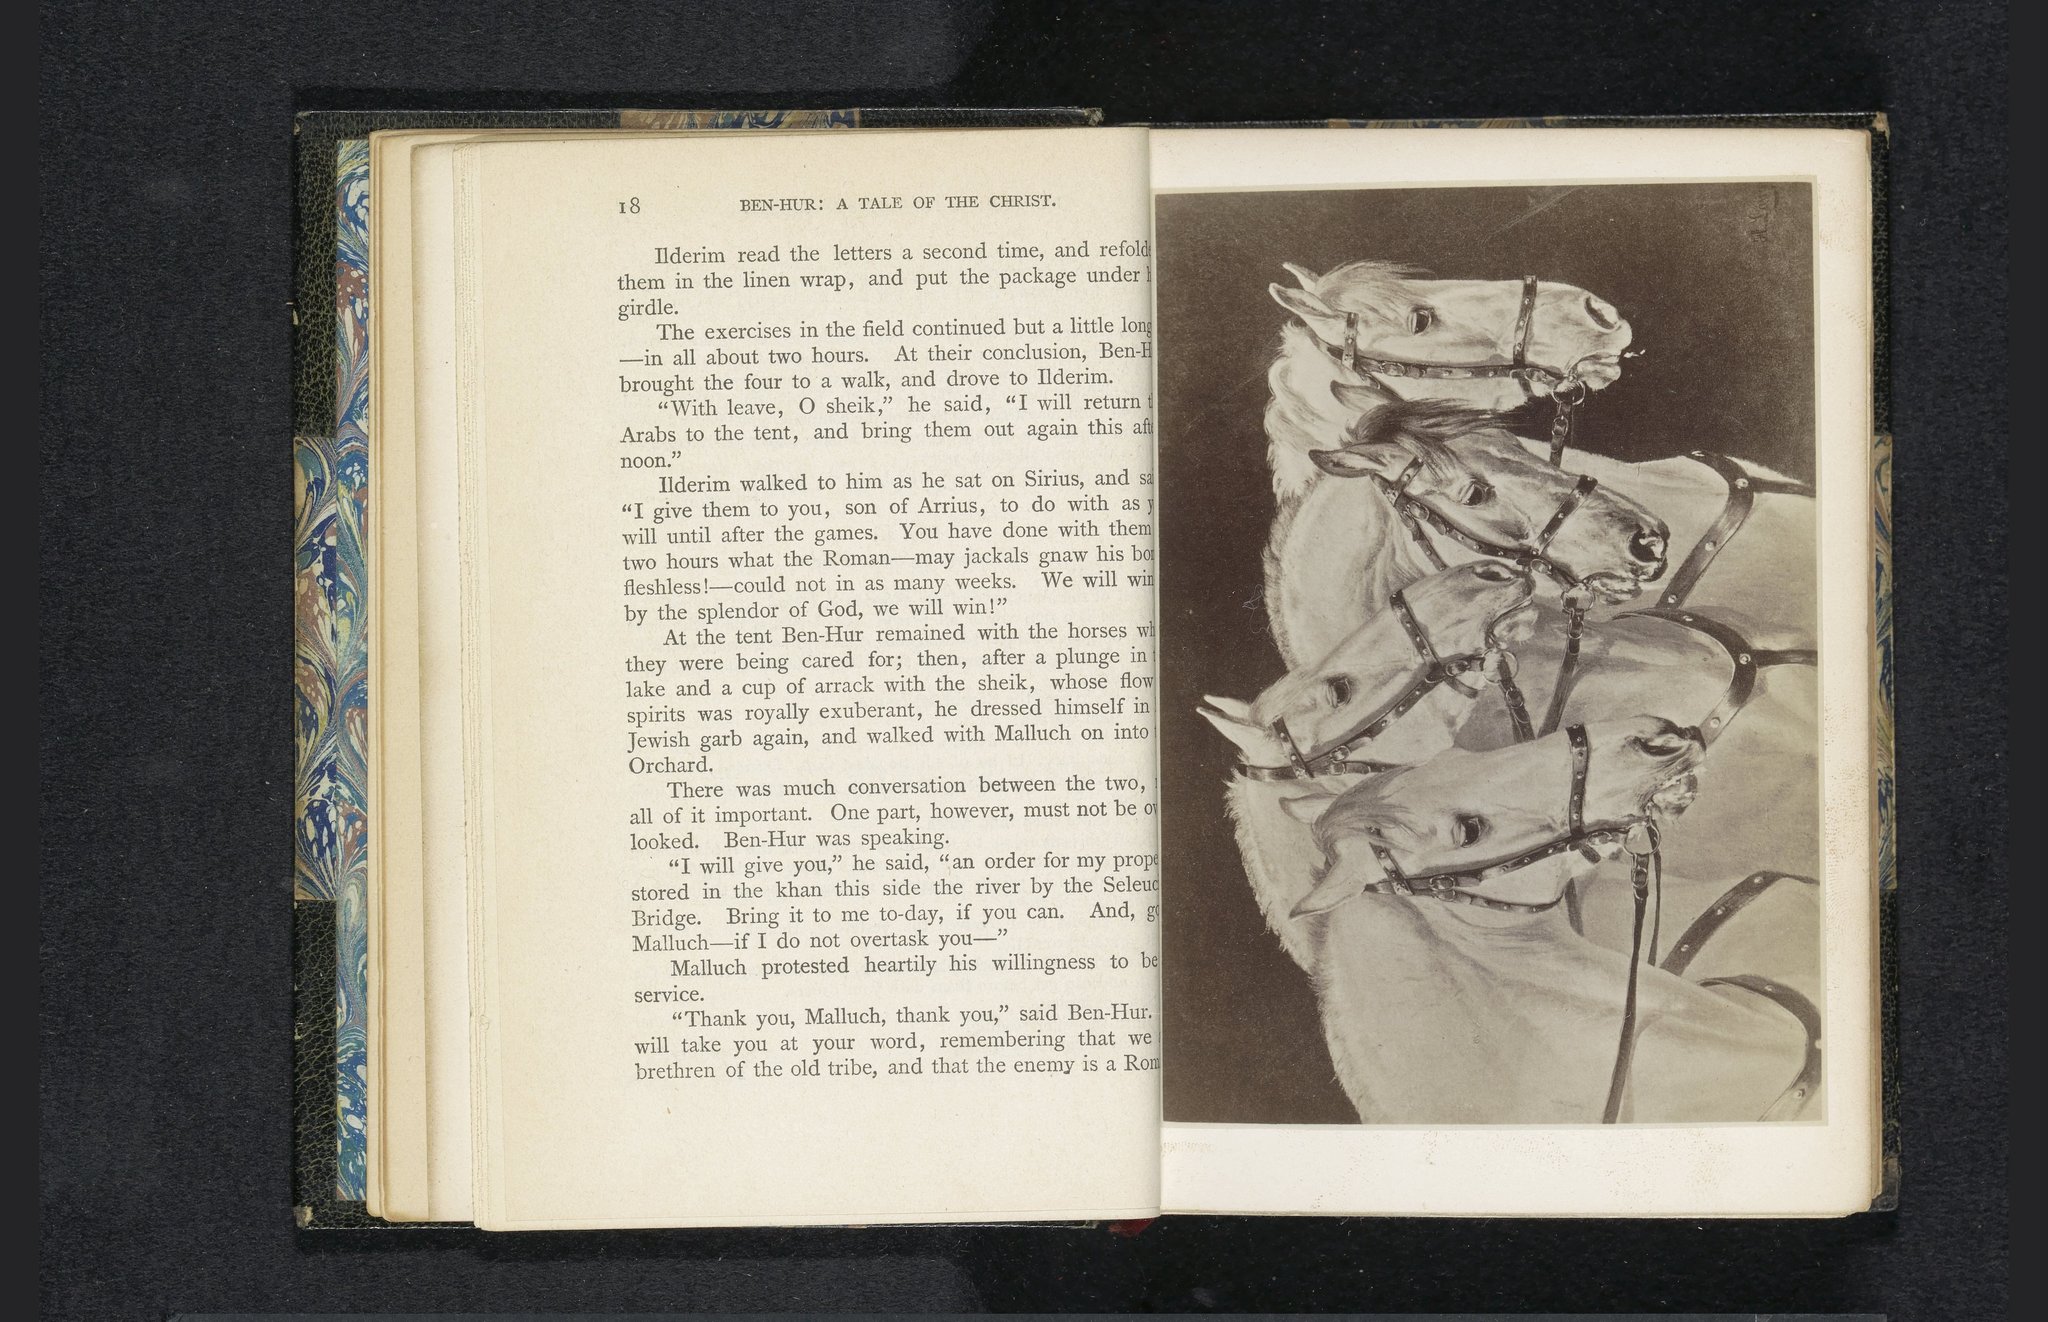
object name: page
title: Fotoreproductie van een schilderij, voorstellende vier paarden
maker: Anonymous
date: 1883-1888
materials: photographic support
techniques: albumen print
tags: horse